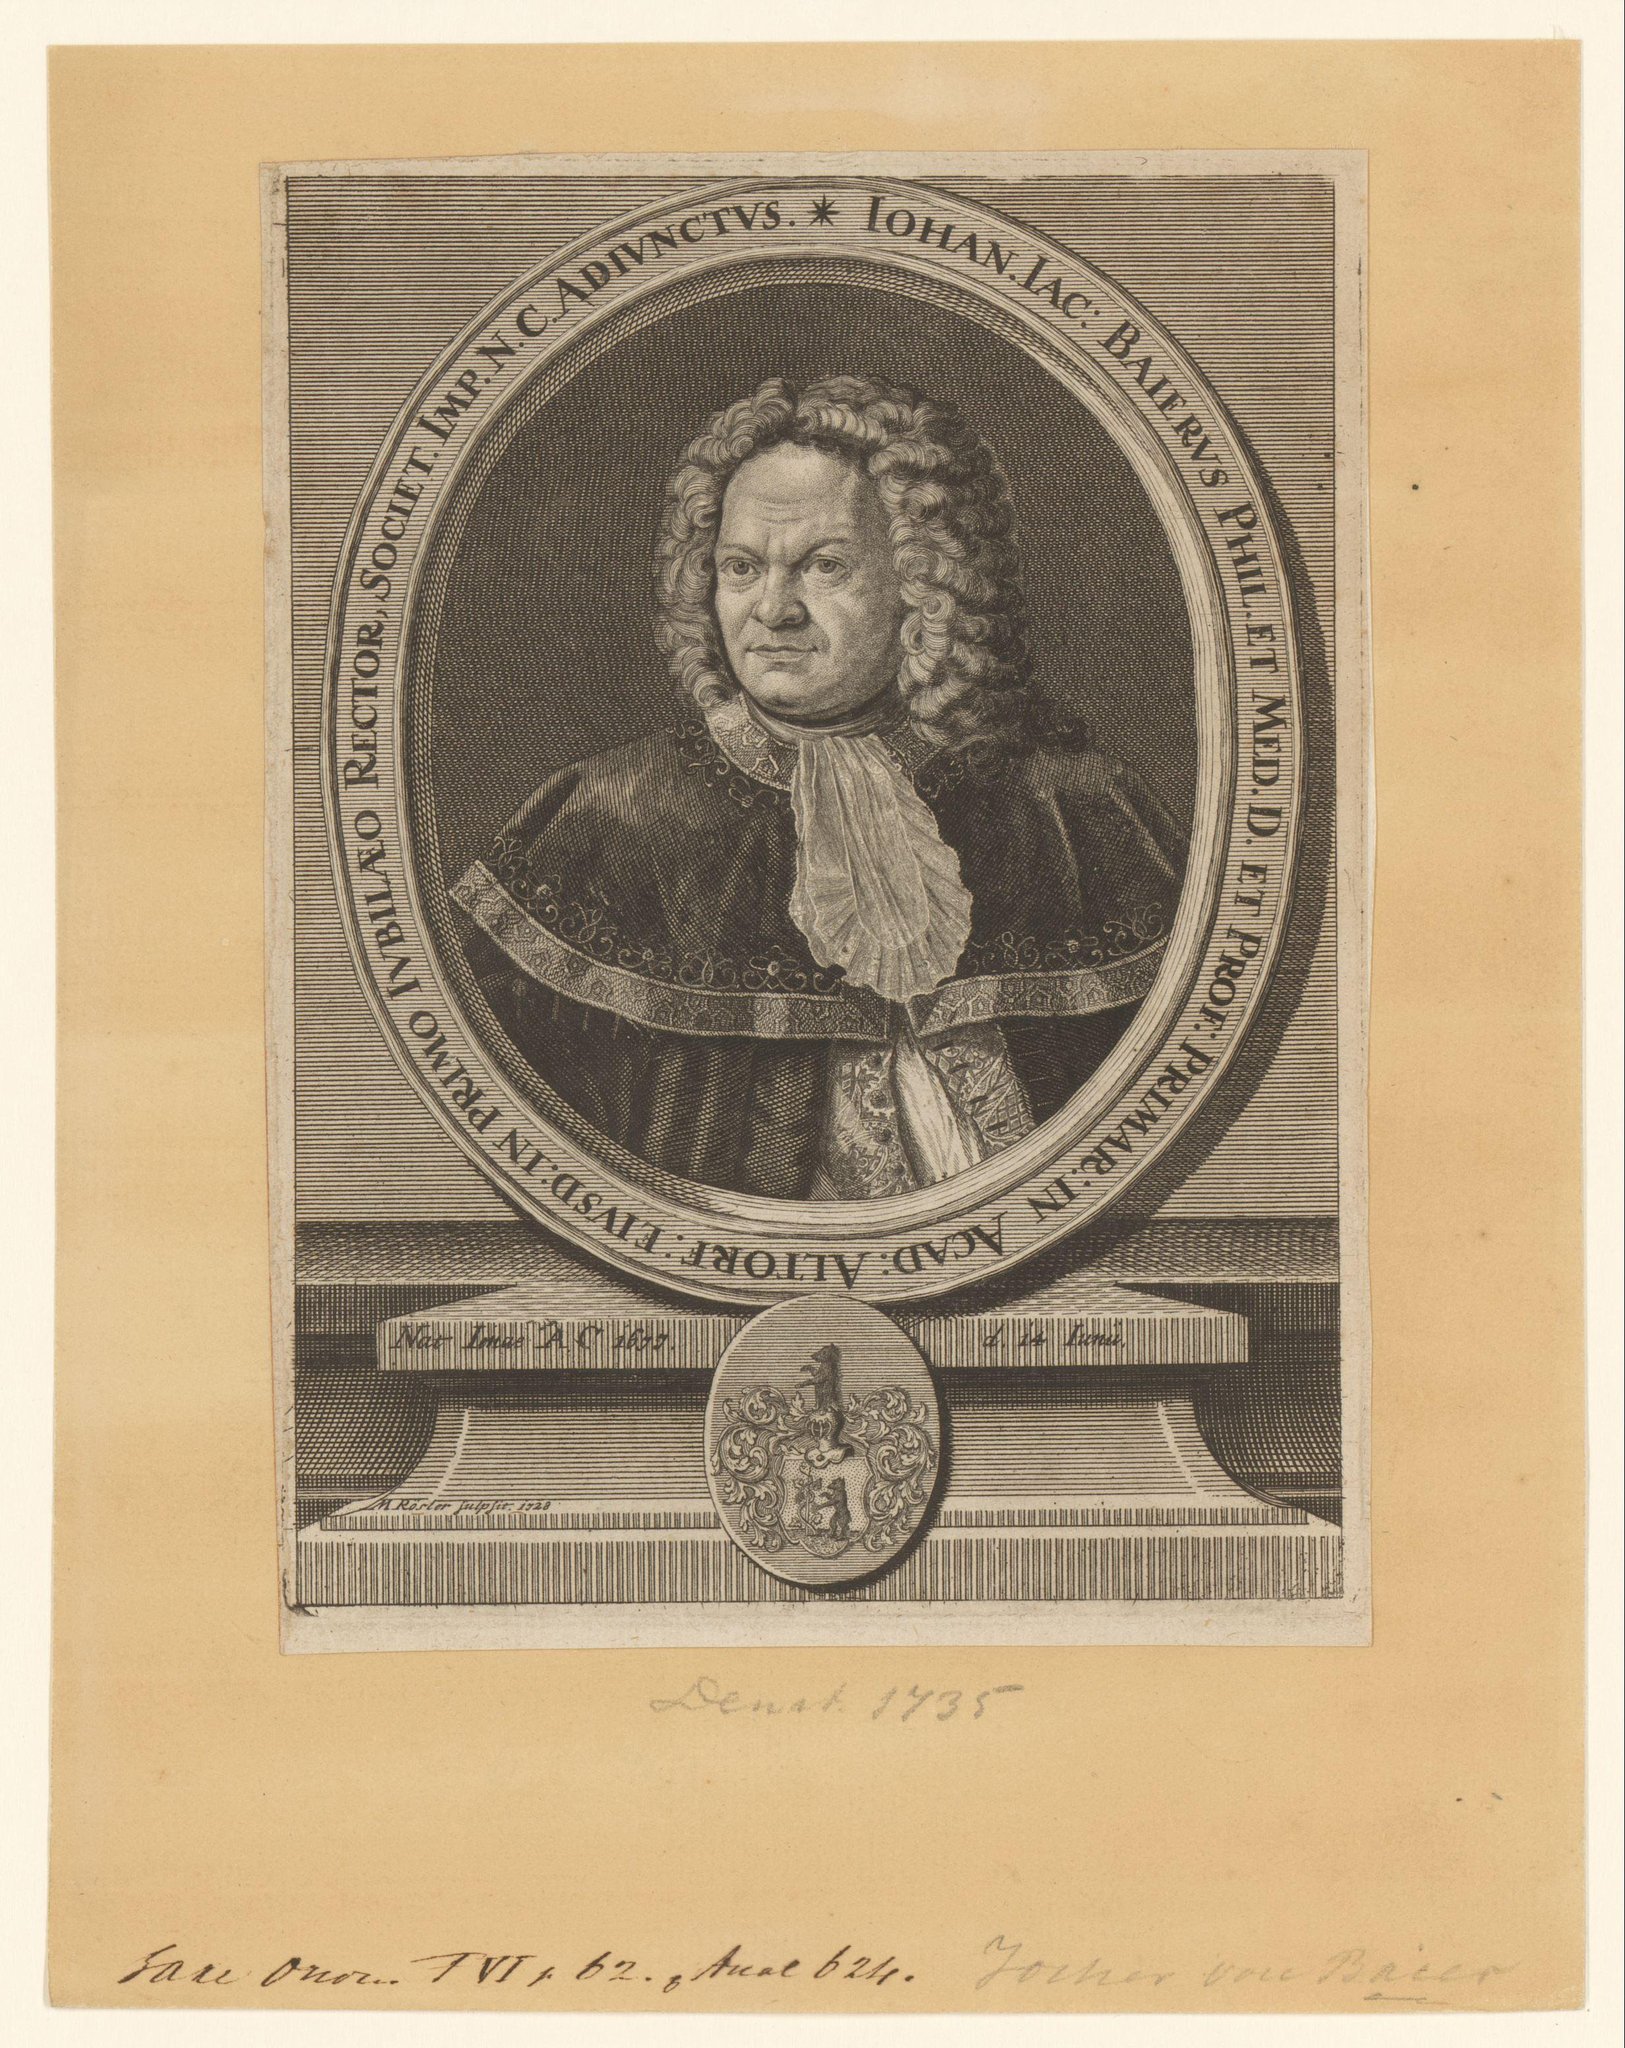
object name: print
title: Portret van Johann Jacob Baier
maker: michael rössler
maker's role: print maker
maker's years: 1705-1777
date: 1728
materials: paper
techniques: engraving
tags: johann jacob baier (i), historical persons, armorial bearing, heraldry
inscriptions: collector's mark: Lugt 2228